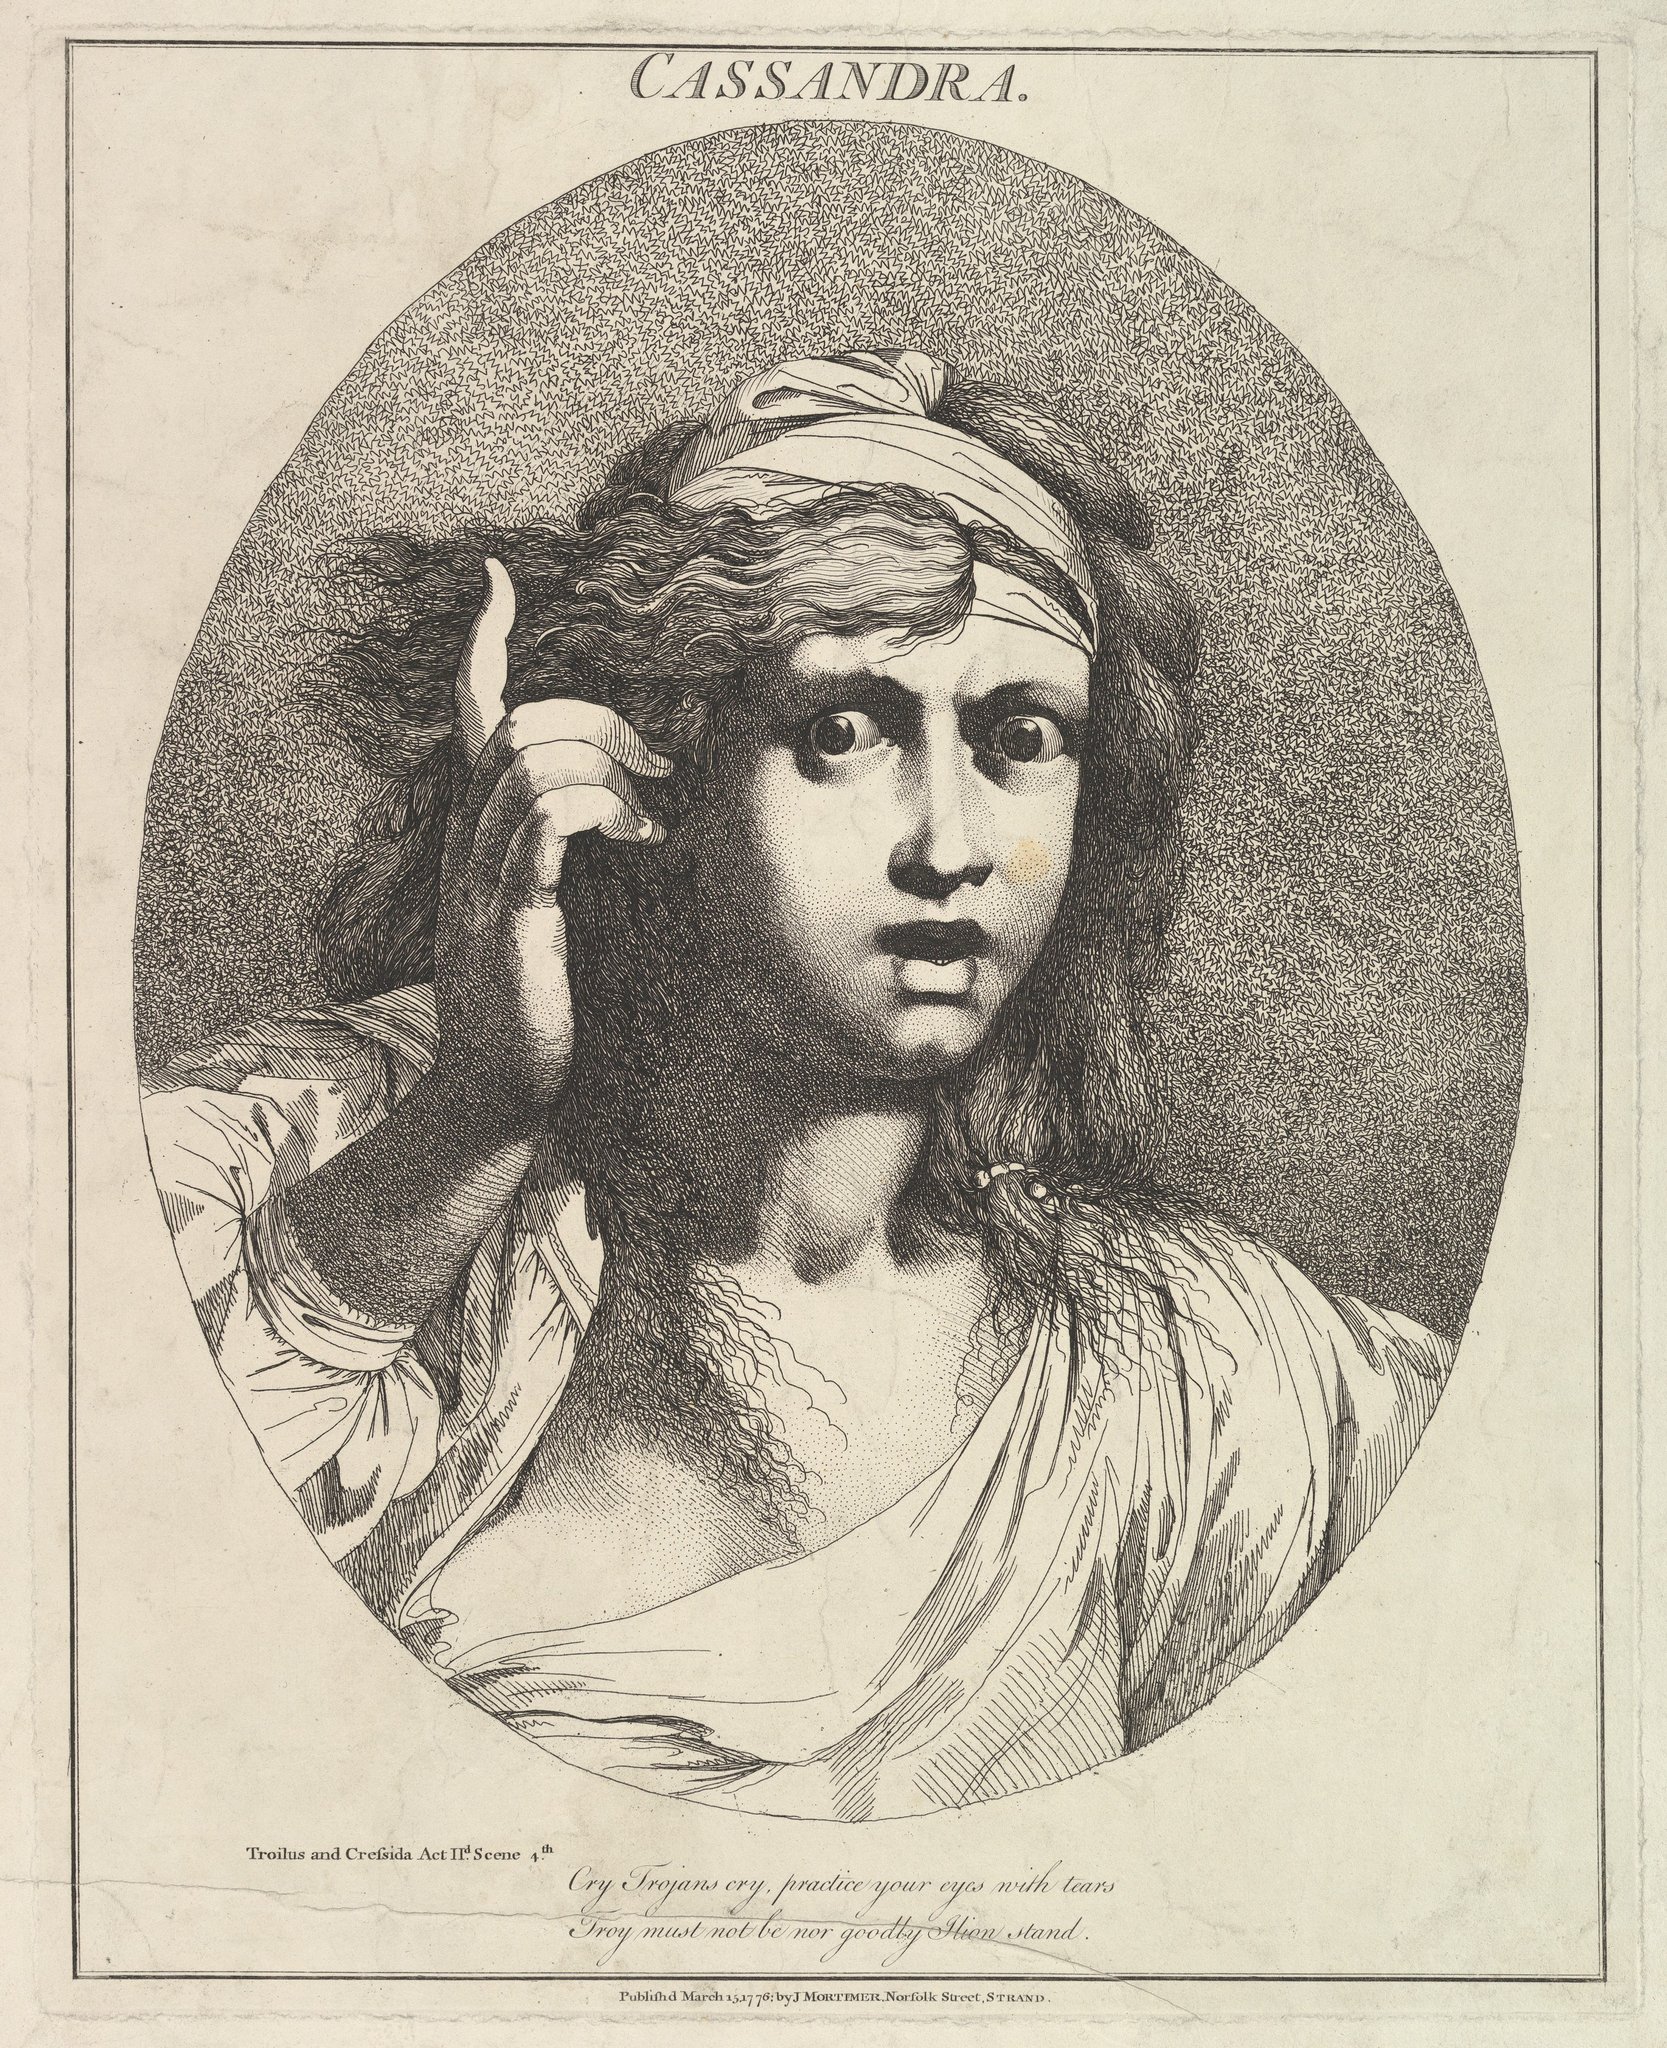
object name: print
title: Cassandra, from "Twelve Characters from Shakespeare"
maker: john hamilton mortimer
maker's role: artist and publisher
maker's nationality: british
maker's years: 1740-1779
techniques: etching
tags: shakespeare,women